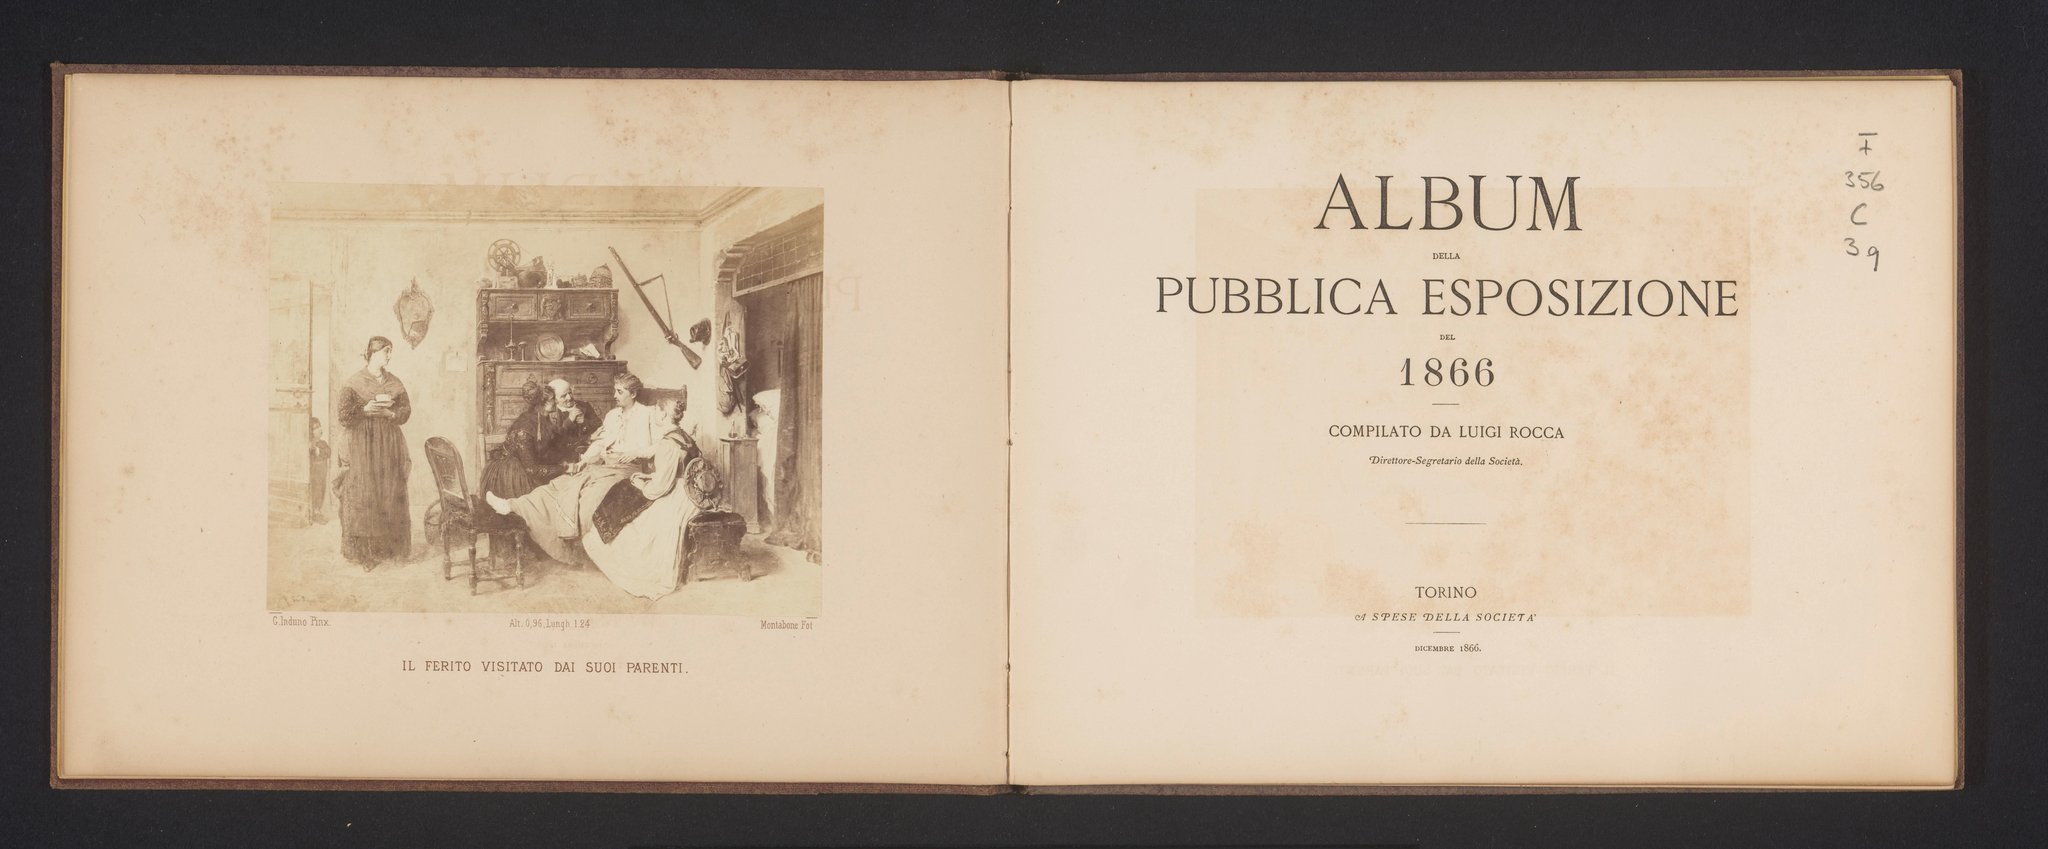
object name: book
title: Album della pubblica esposizione del 1866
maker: luigi rocca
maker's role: auteur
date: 1866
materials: cardboard, linen, paper, photographic support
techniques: albumen print, printing